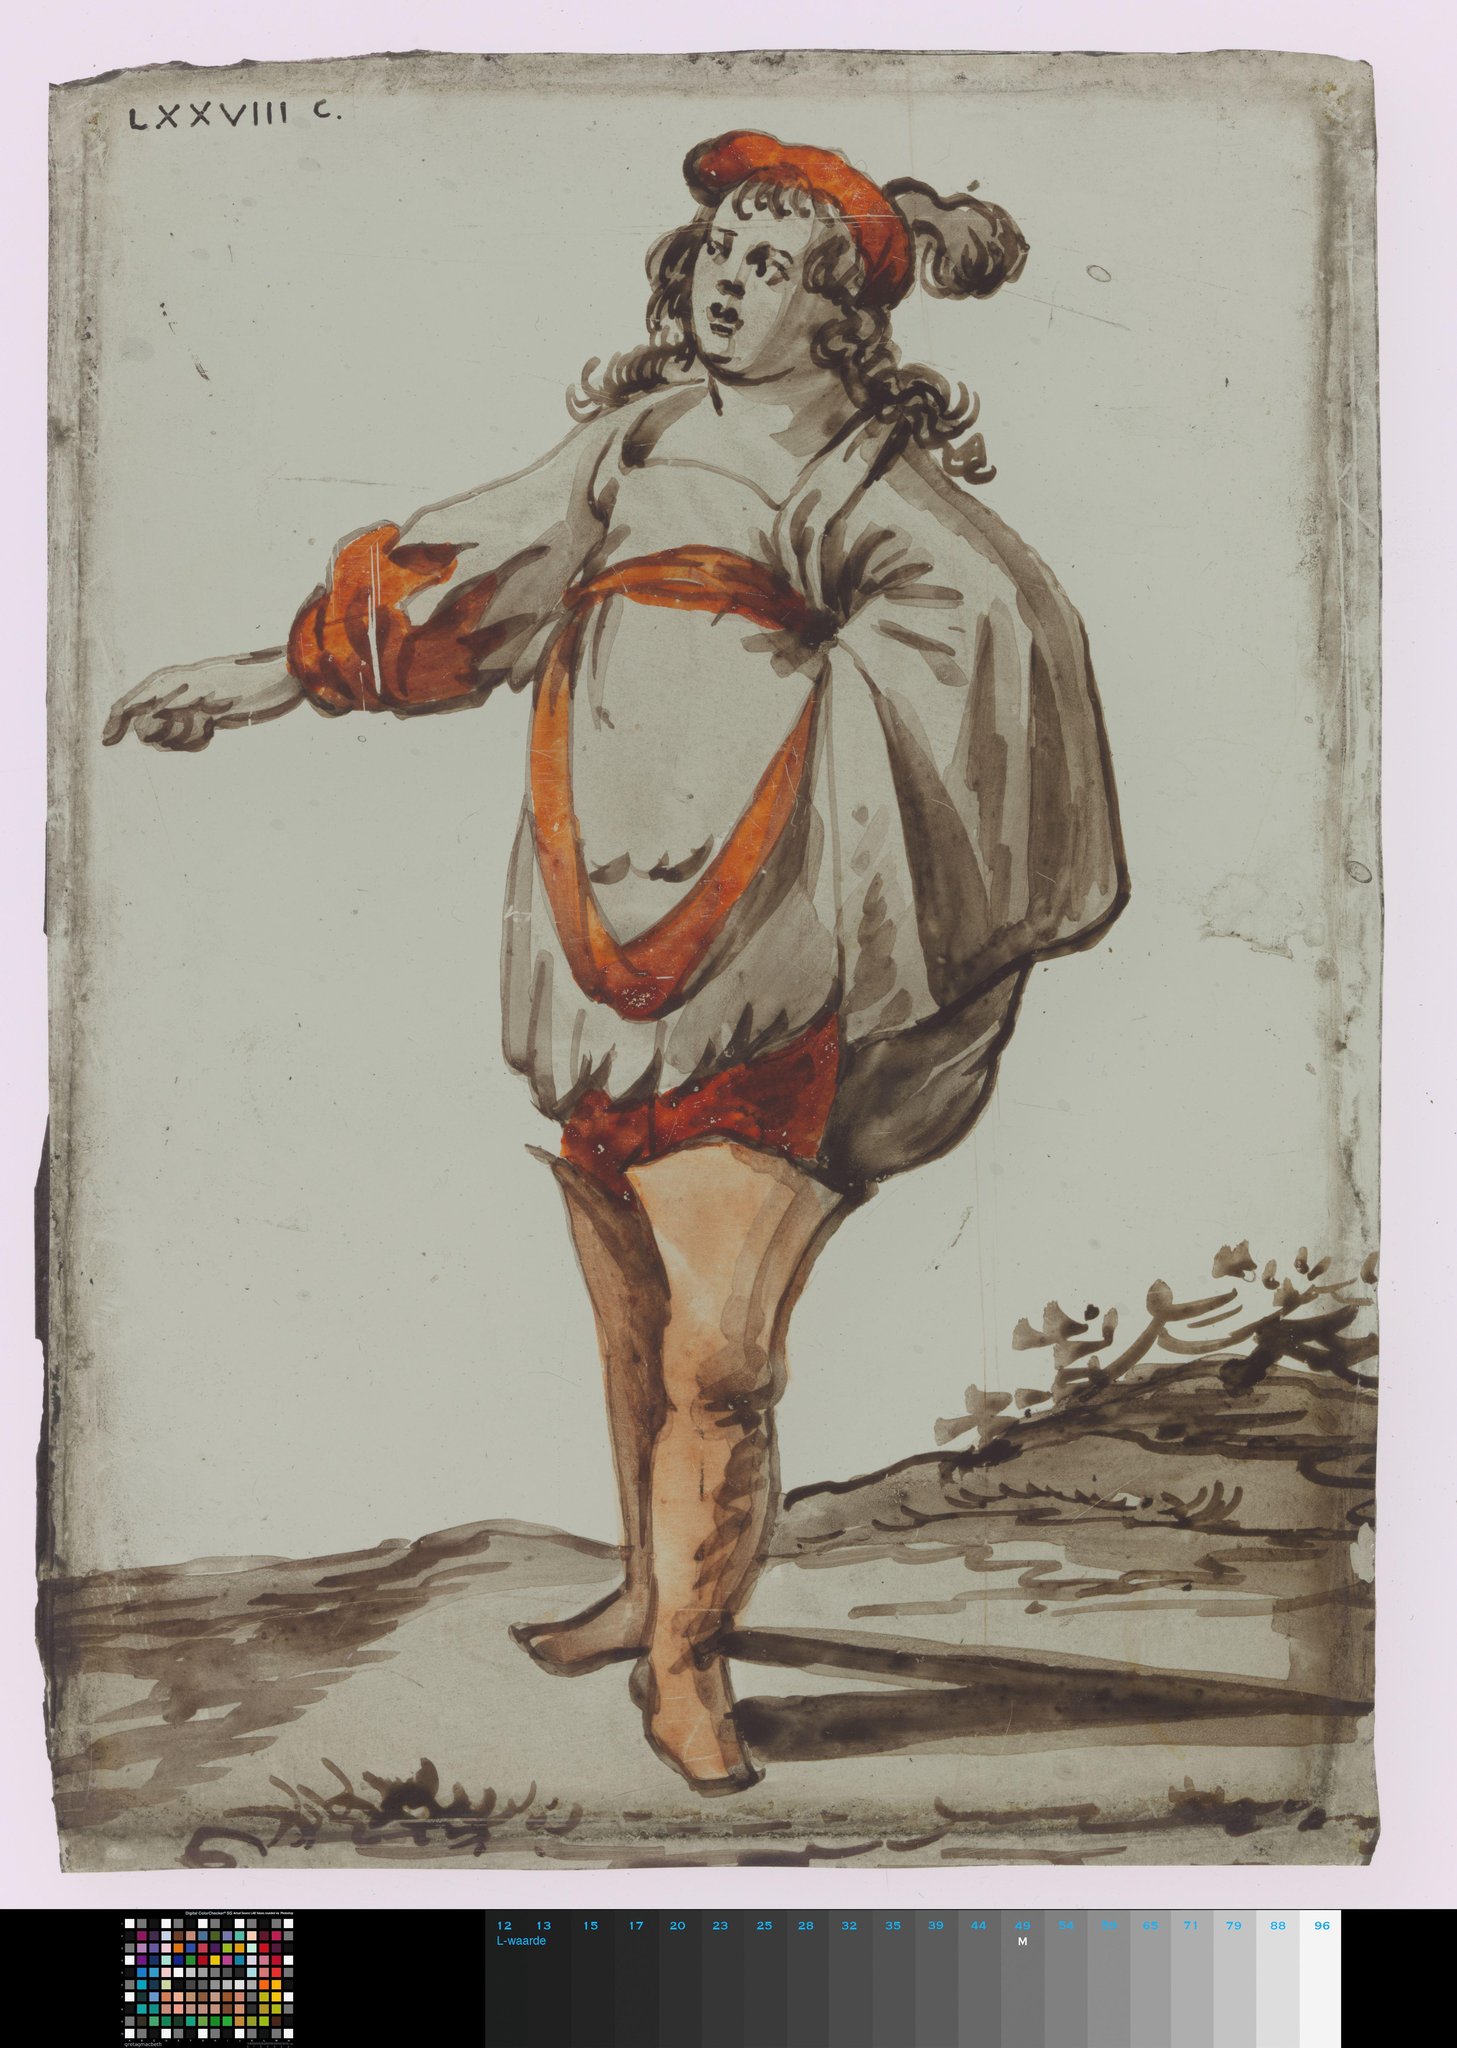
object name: light window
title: Ruit met een jongeman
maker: Anonymous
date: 1650-1675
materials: glass, lead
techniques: enamel painting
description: Een ruit met emailschildering van een jongeman in fantasiekostuum staande in een landschap, gekleurd.